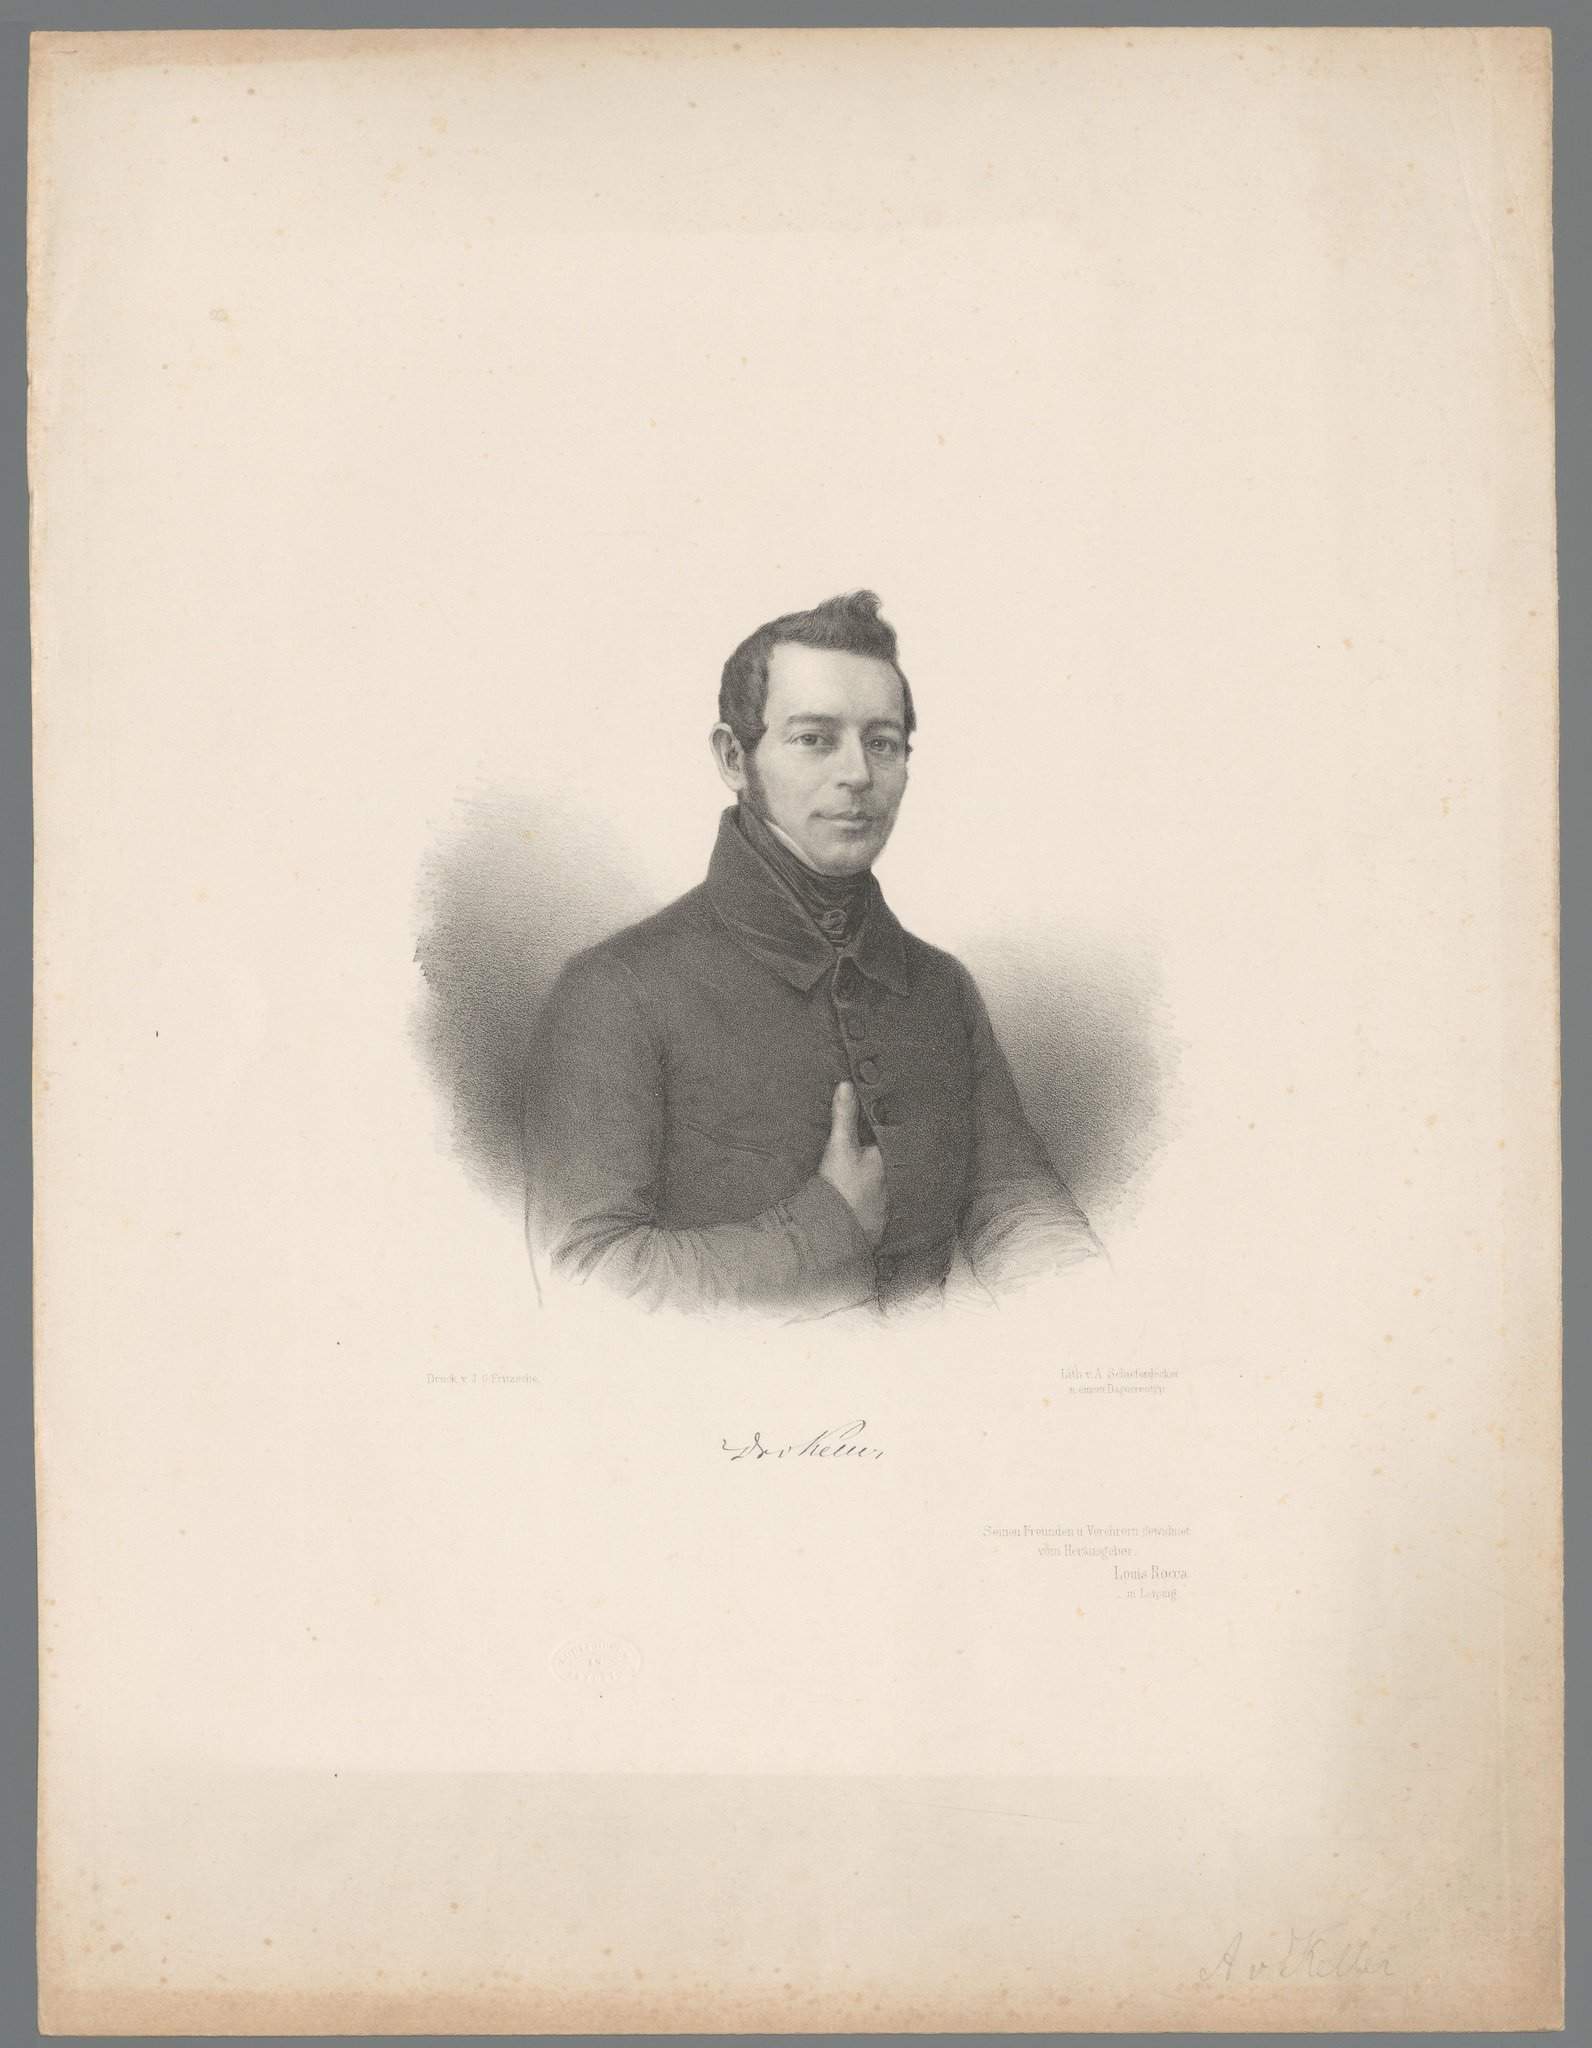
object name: print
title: Portret van Augustin Keller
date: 1833-1878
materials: paper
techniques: lithograph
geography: leipzig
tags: politician, historical persons, politician, e.g. party leader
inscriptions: collector's mark: Lugt 2228, check stamp: ‘Louis Rocca in Leipzig’